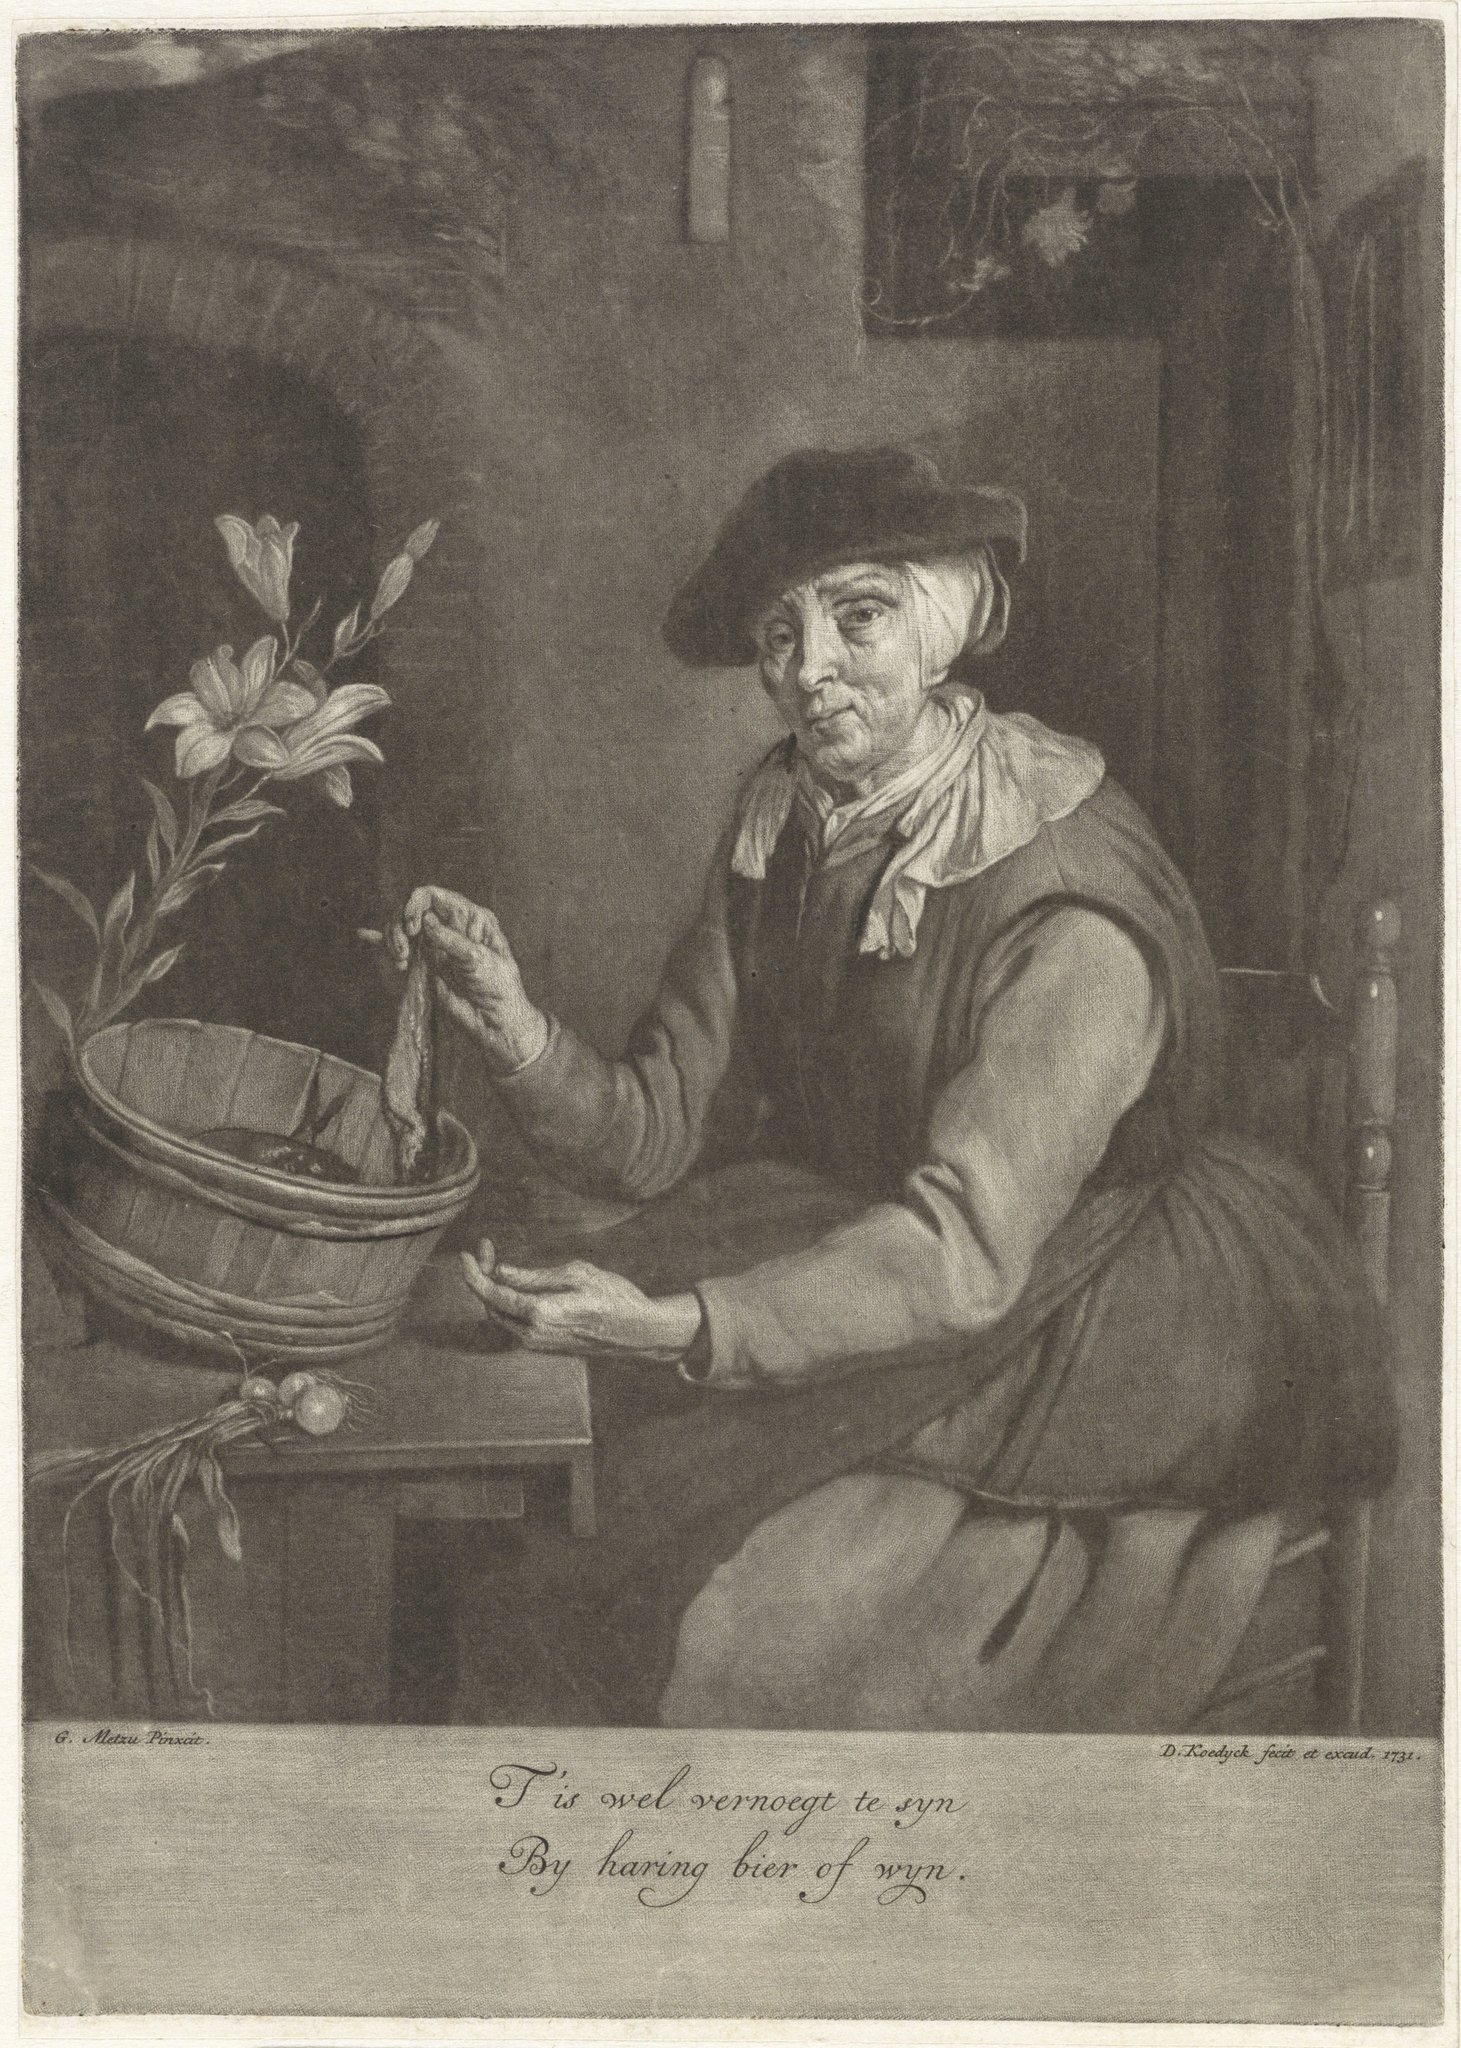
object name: print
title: Oude vrouw met een haring in de hand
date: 1731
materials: paper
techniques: engraving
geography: zaandam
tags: bony fishes: herring, old woman, (non-fruit) products of plants or trees: onion, flowers: lily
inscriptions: collector's mark: Lugt 2228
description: Een oude vrouw zit in de buitenlucht aan een tafel en houdt een haring in de hand. Op de tafel staat een houten bak met haringen en ligt een bosje uien.